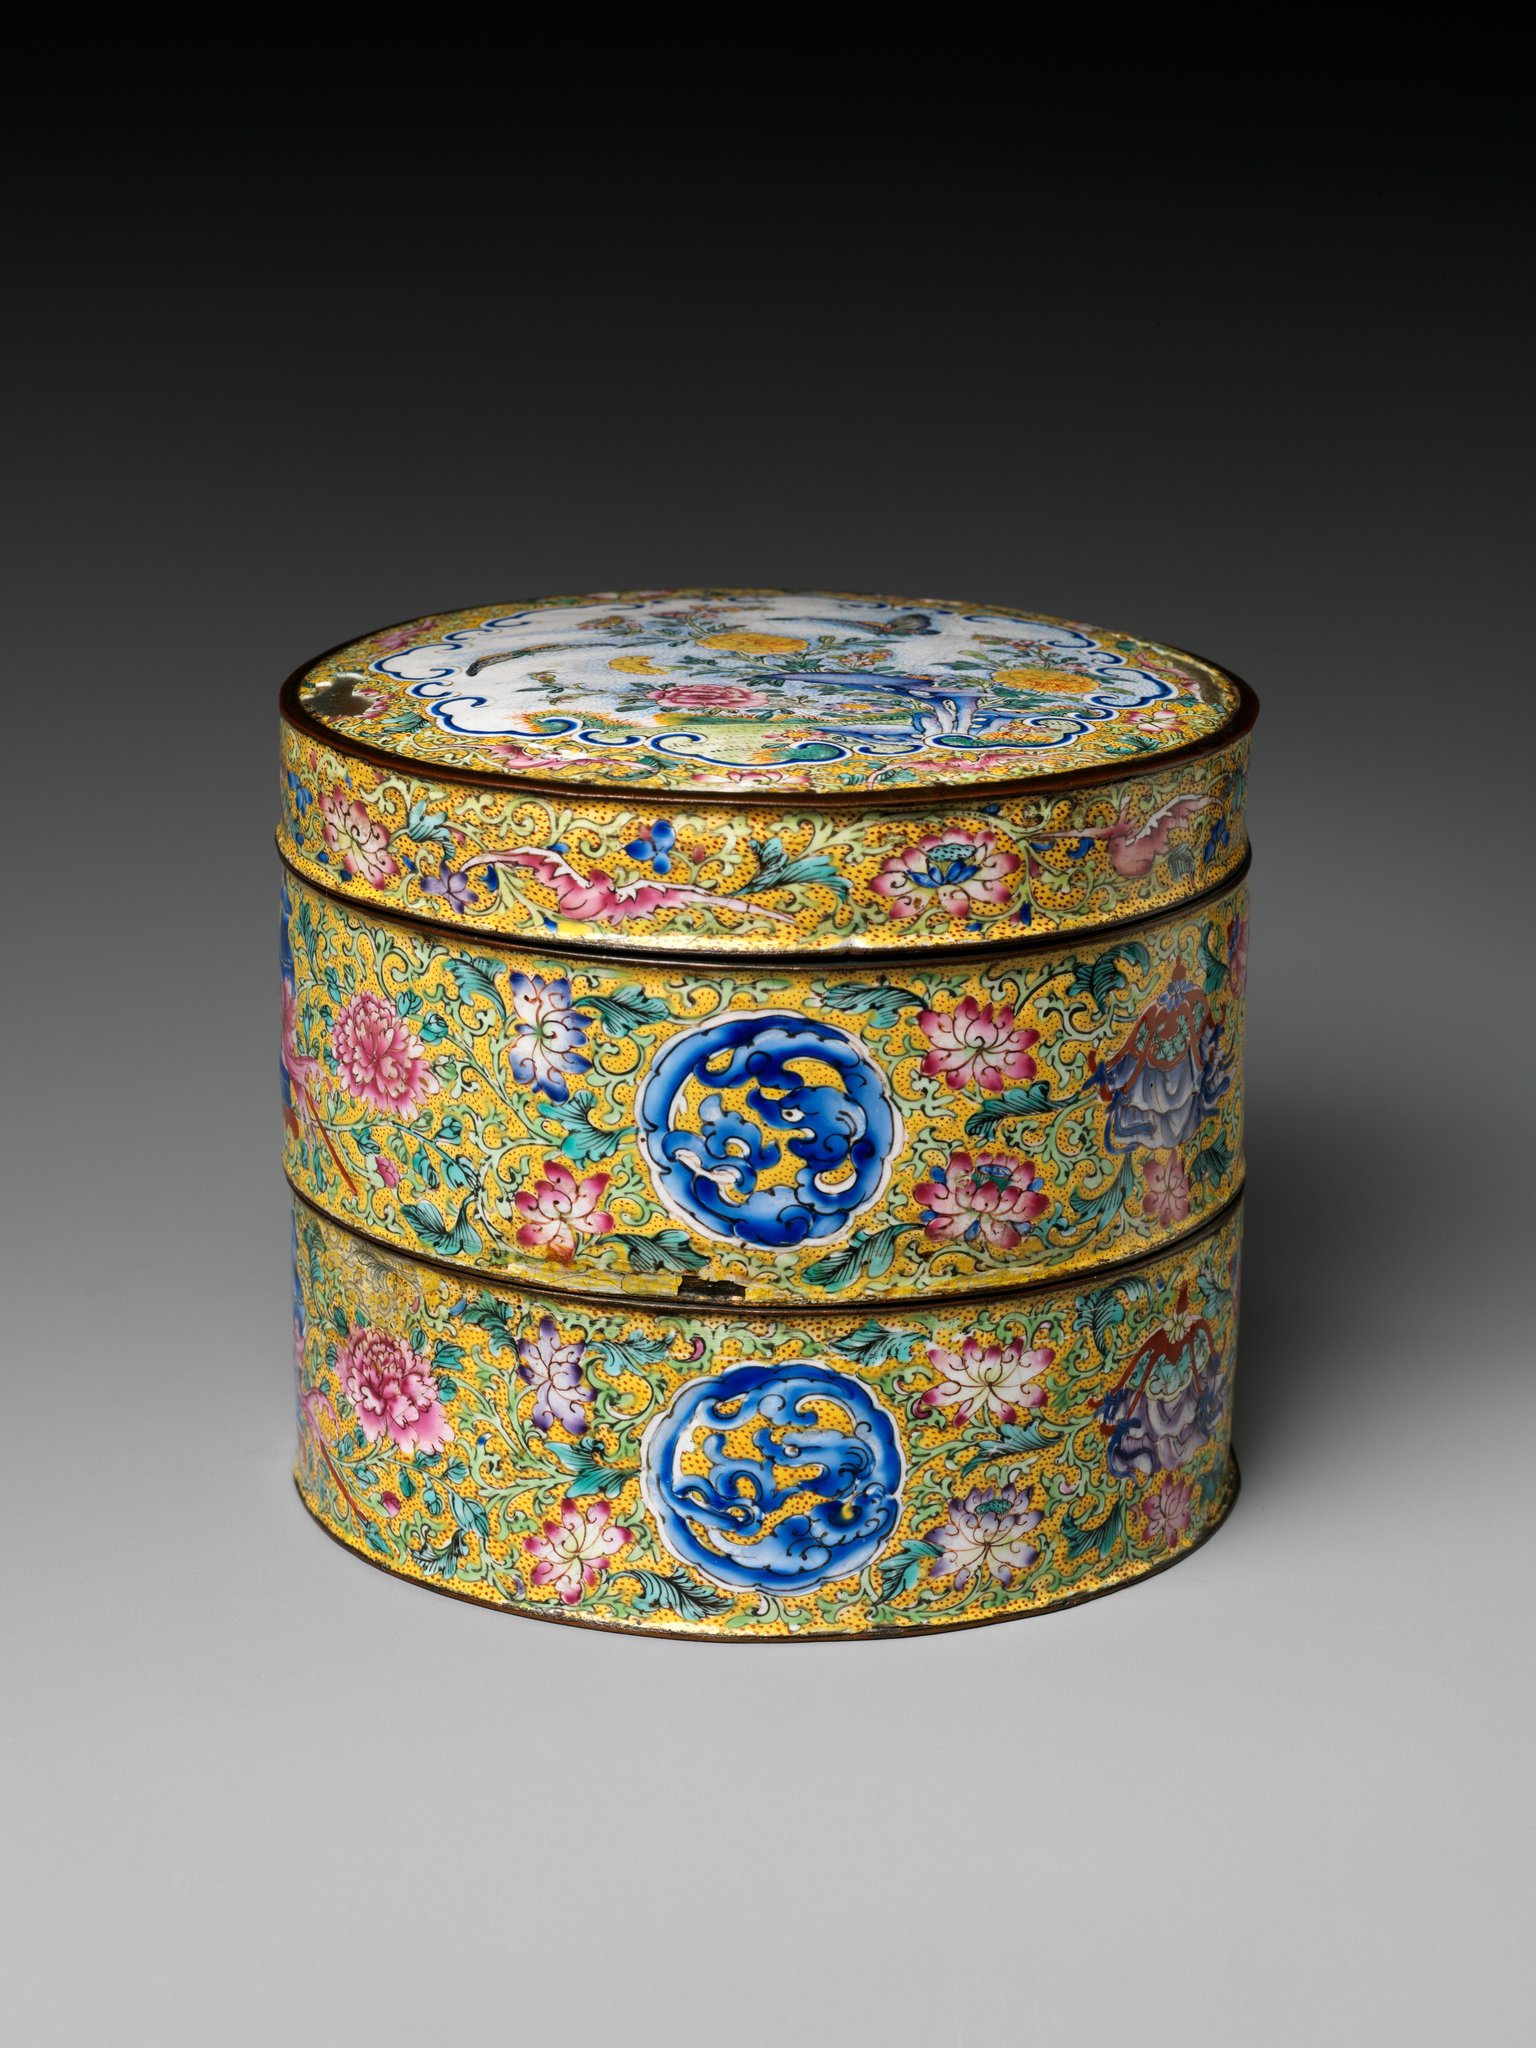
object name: box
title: Covered Box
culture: chinese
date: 1701-1800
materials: copper, enamel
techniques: painting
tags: flowers